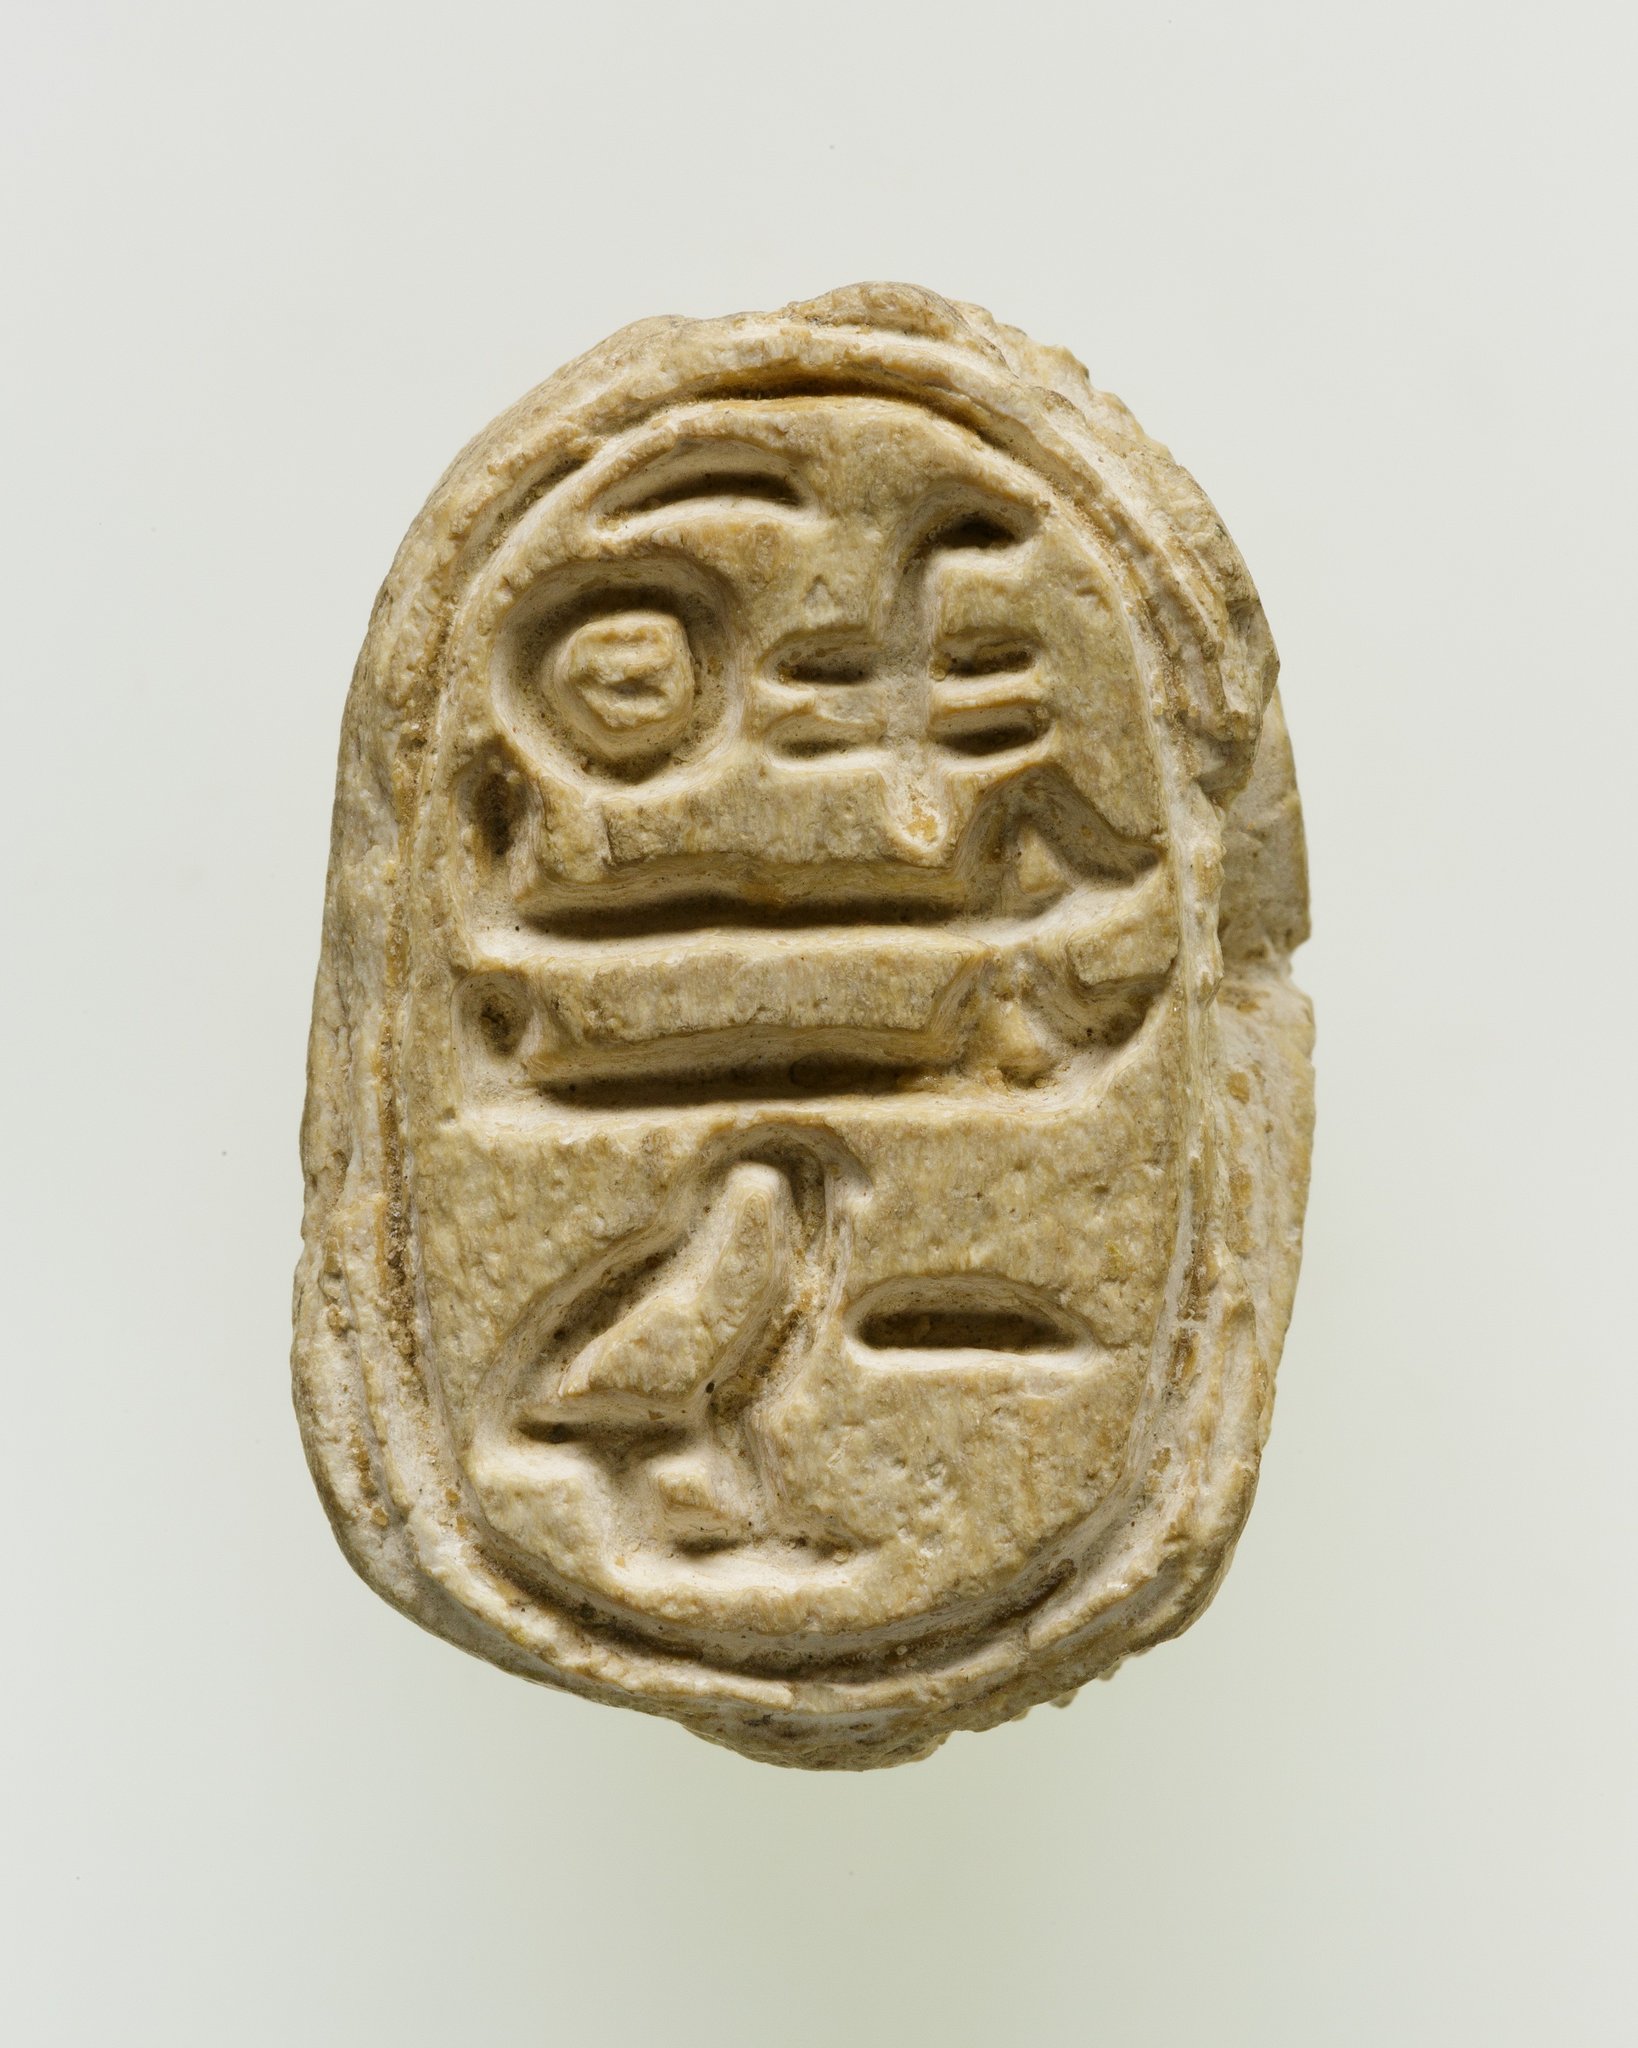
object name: scarab, official, private name and title, iti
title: Scarab of an Official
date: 1760-1670 BCE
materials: stone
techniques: glazing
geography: egypt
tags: hieroglyphs,scarabs